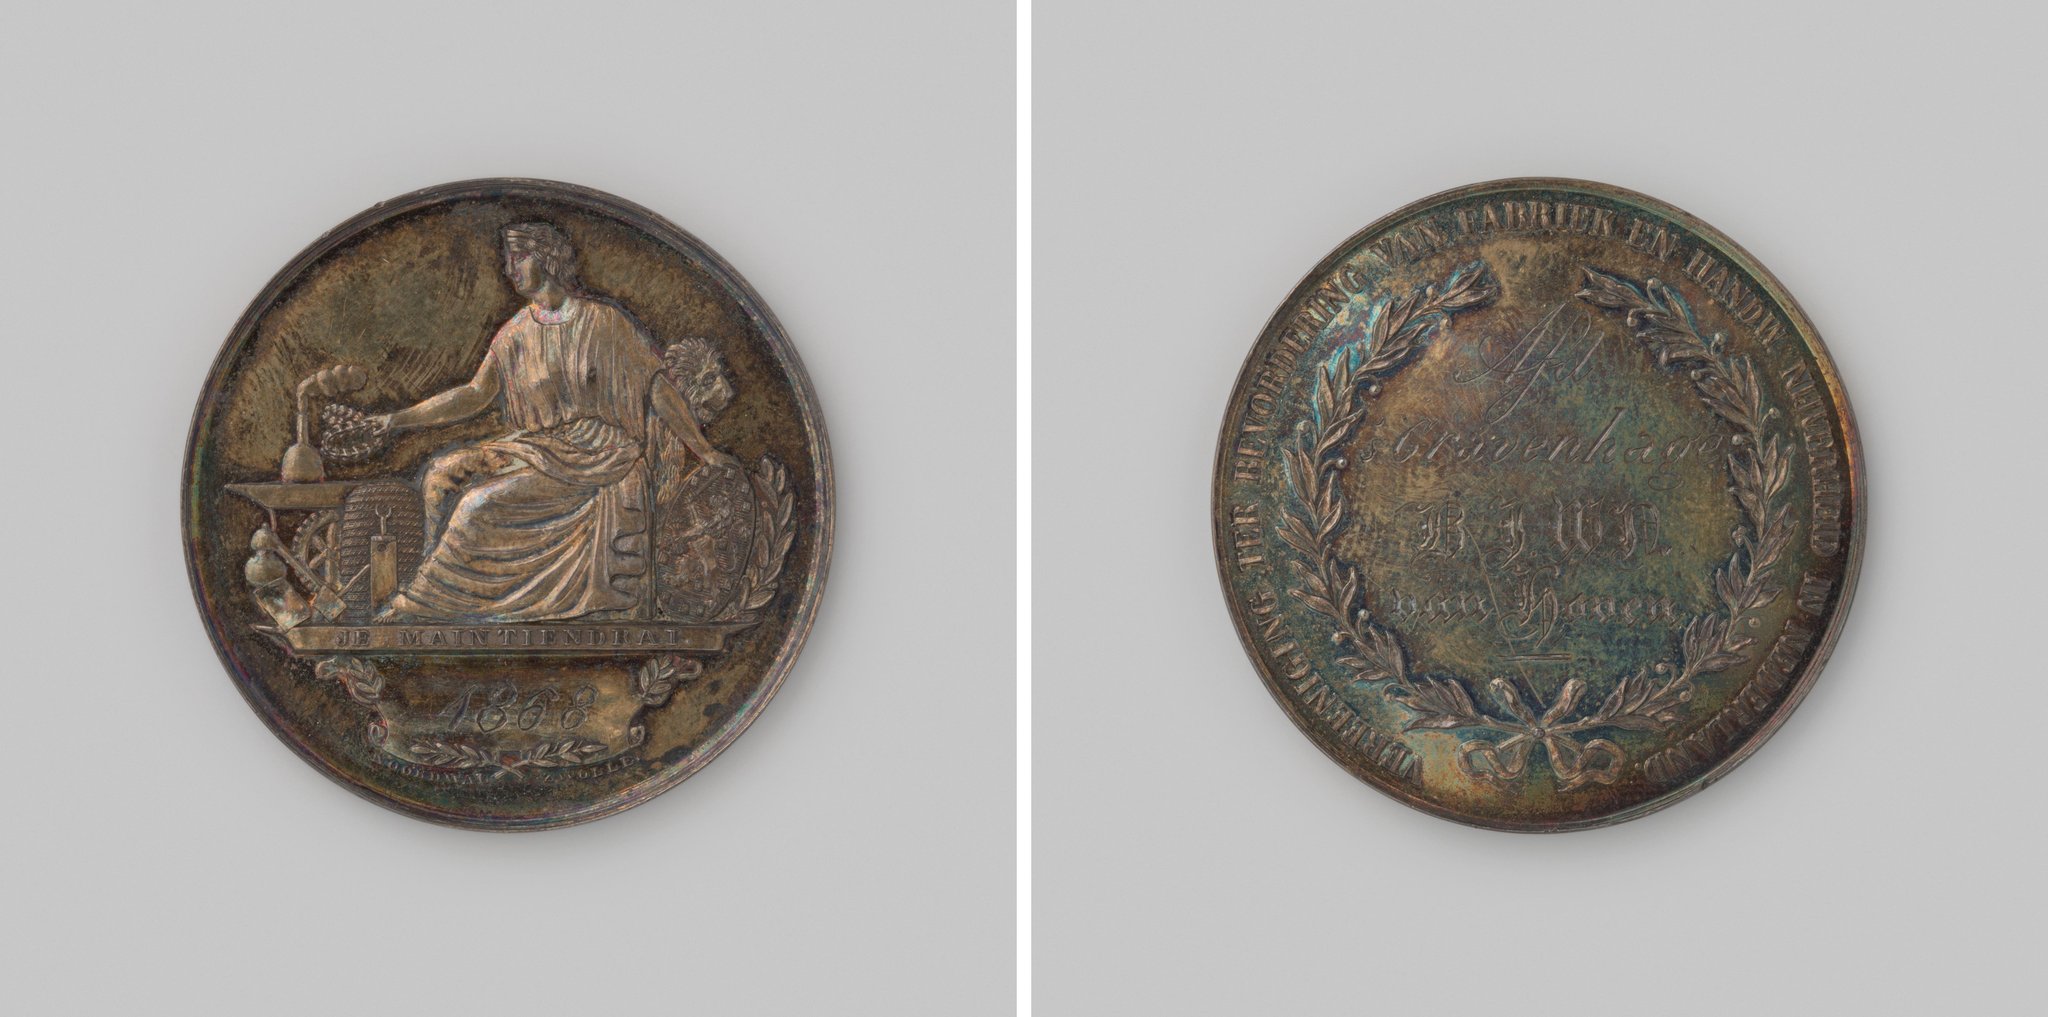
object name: medal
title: Prijspenning, verleend aan Bart van Hove in 1868 door de Vereeniging ter bevordering van fabriek en handwerknijverheid in Nederland, afdeling 's Gravenhage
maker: noordwal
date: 1868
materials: silver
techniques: engraving, striking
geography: zwolle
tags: amsterdam, sculptor, bart van hove, the hague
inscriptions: inscription: ‘Afd 's Gravenhage B.J.W.N. van Hoven’, circumscription: ‘VEREENIGING TER BEVORDERING VAN FABRIEK EN HANDW. NIJVERHEID IN NEDERLAND.’, date: ‘1868’, signature: ‘NOORDWAL ZWOLLE’, inscription: ‘JE MAINTIENDRAI’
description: Zilveren penning. Voorzijde: naar links gekeerde zittende vrouwenfiguur met in linkerhand een wapenschild waarop Nederlandse Leeuw, in de rechterhand twee lauwerkransen. Op de achtergrond links diverse (industriële) gereedschappen en rechts de kop van een leeuw. Onder opschrift, datum en signatuur. Keerzijde: lauwerkrans waarbinnen opschrift en -buiten omschrift.